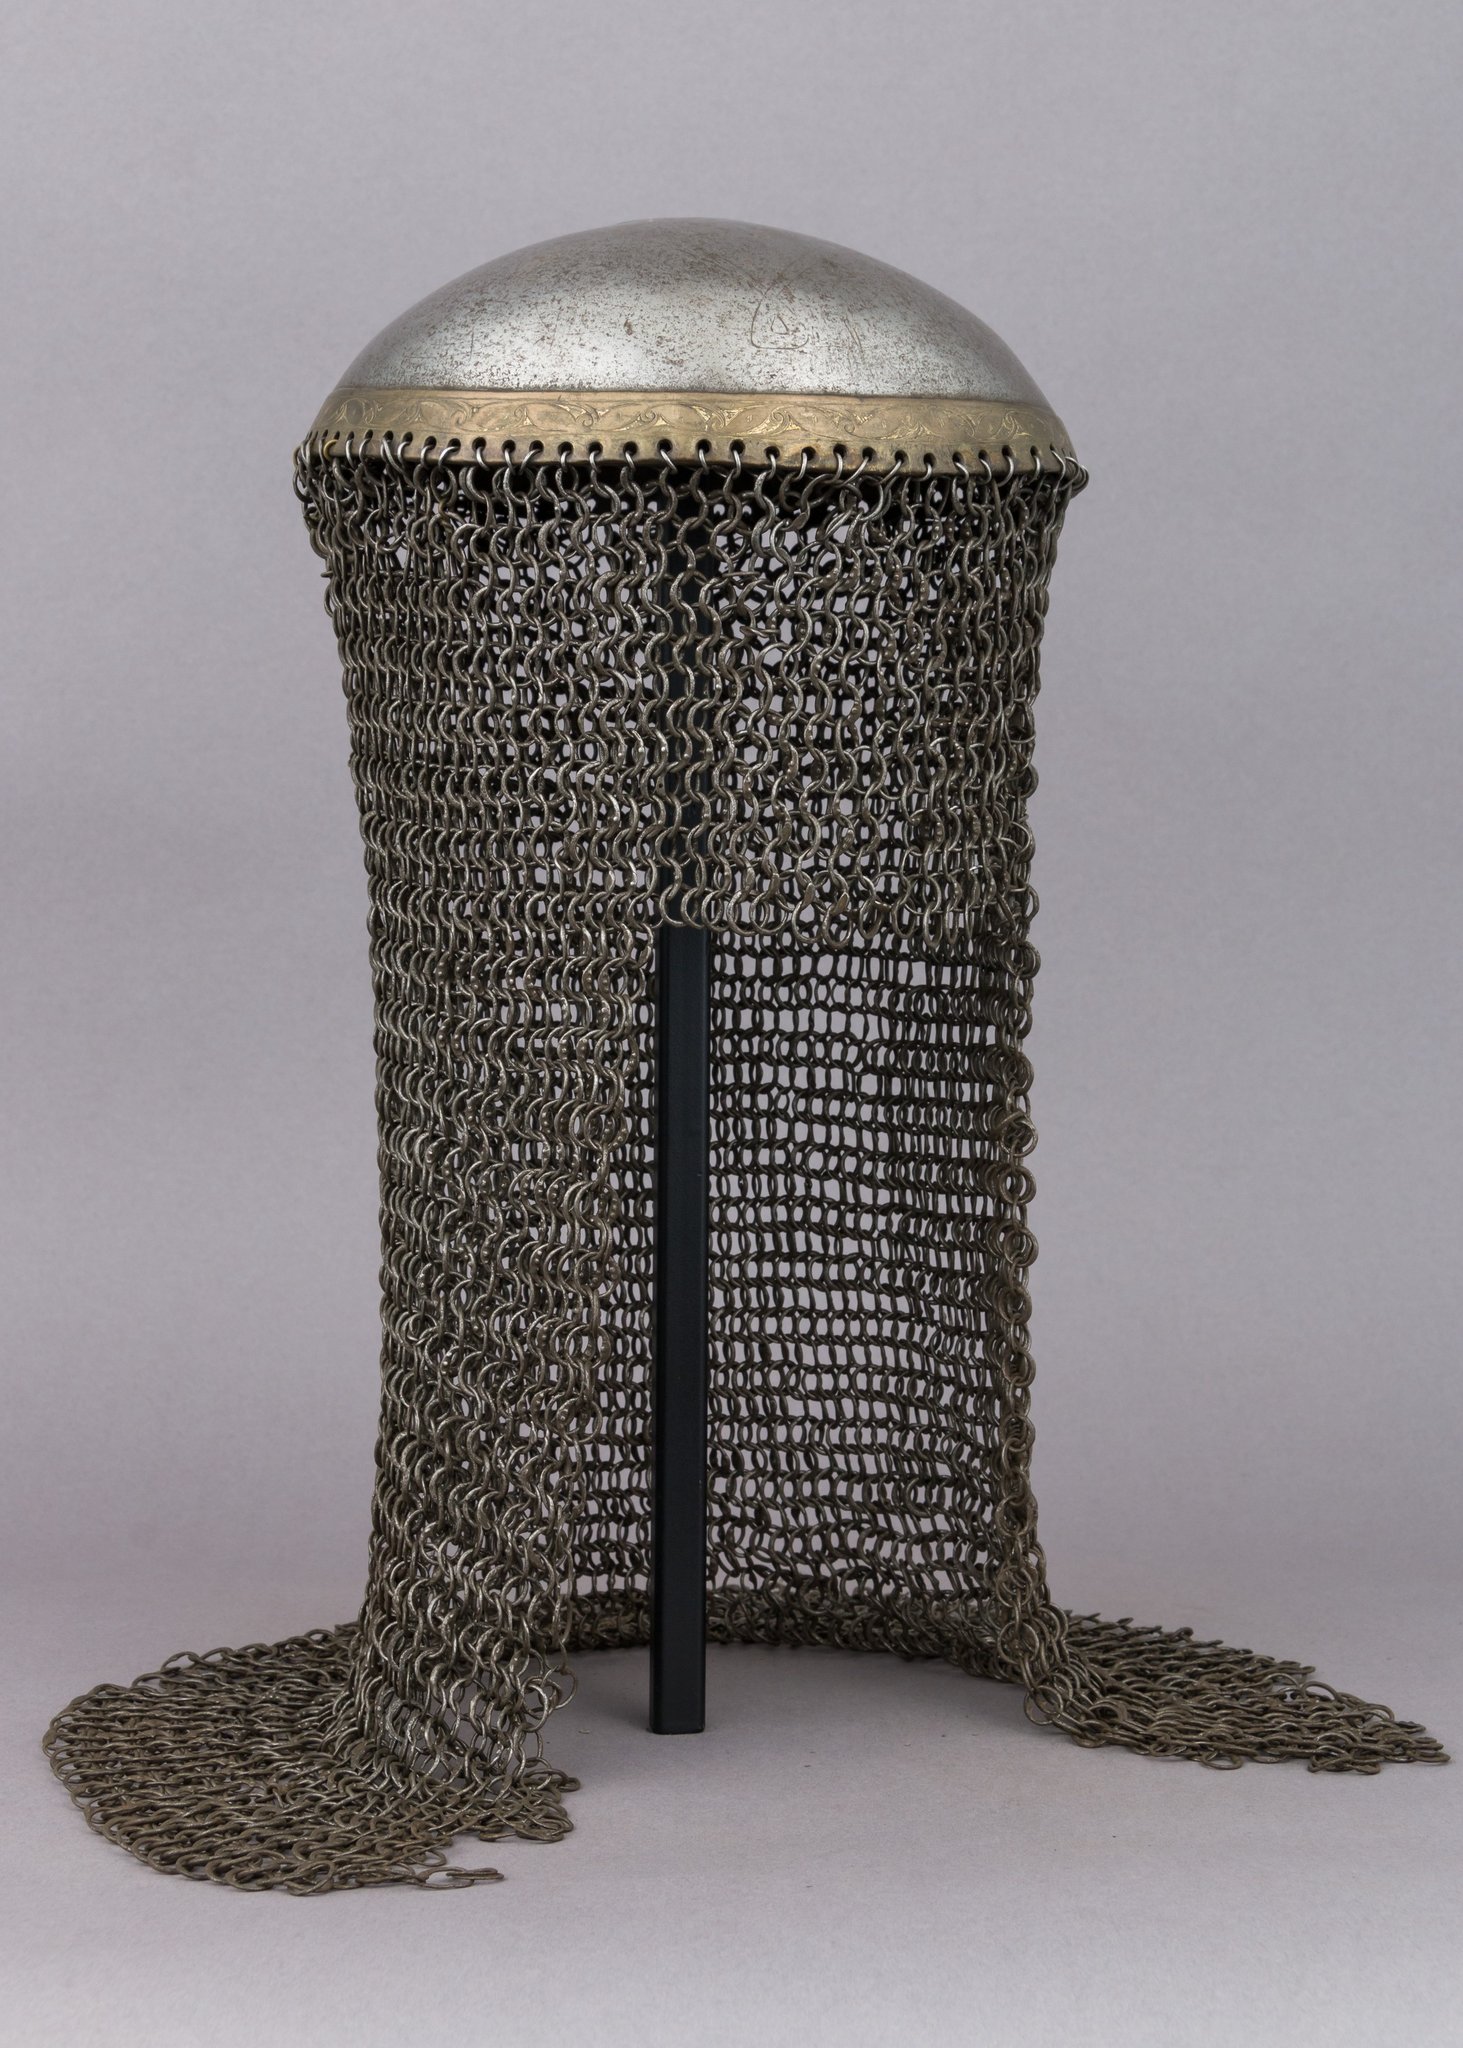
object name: helmet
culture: turkish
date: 1601-1800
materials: brass, gold, iron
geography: ottoman empire